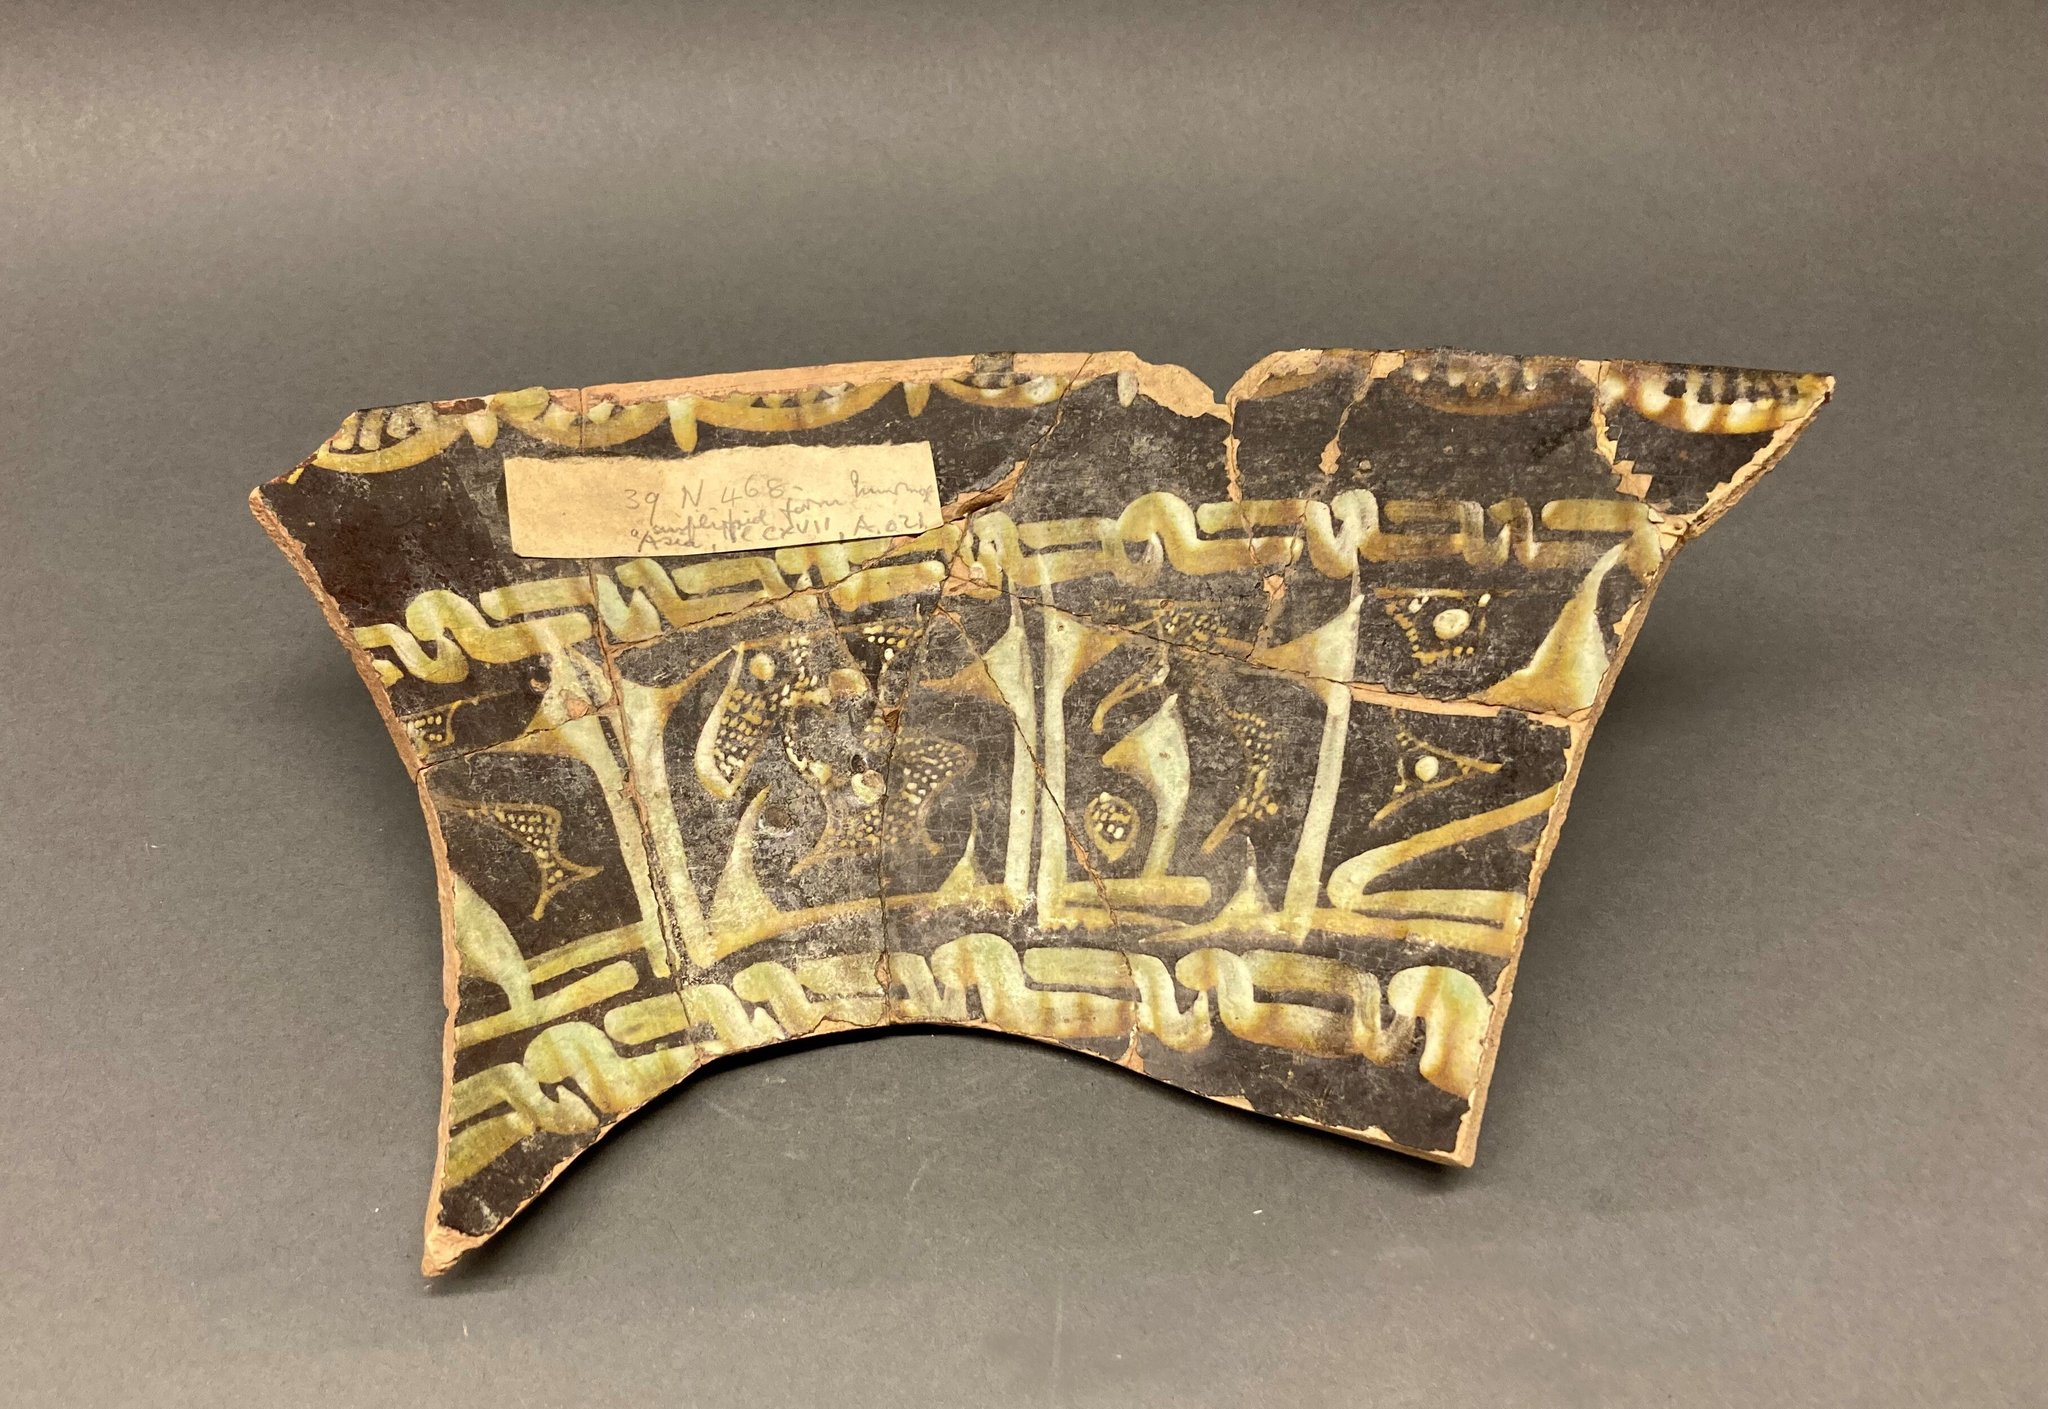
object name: fragment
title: Fragment of a Bowl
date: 801-1000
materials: earthenware, glaze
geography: iran